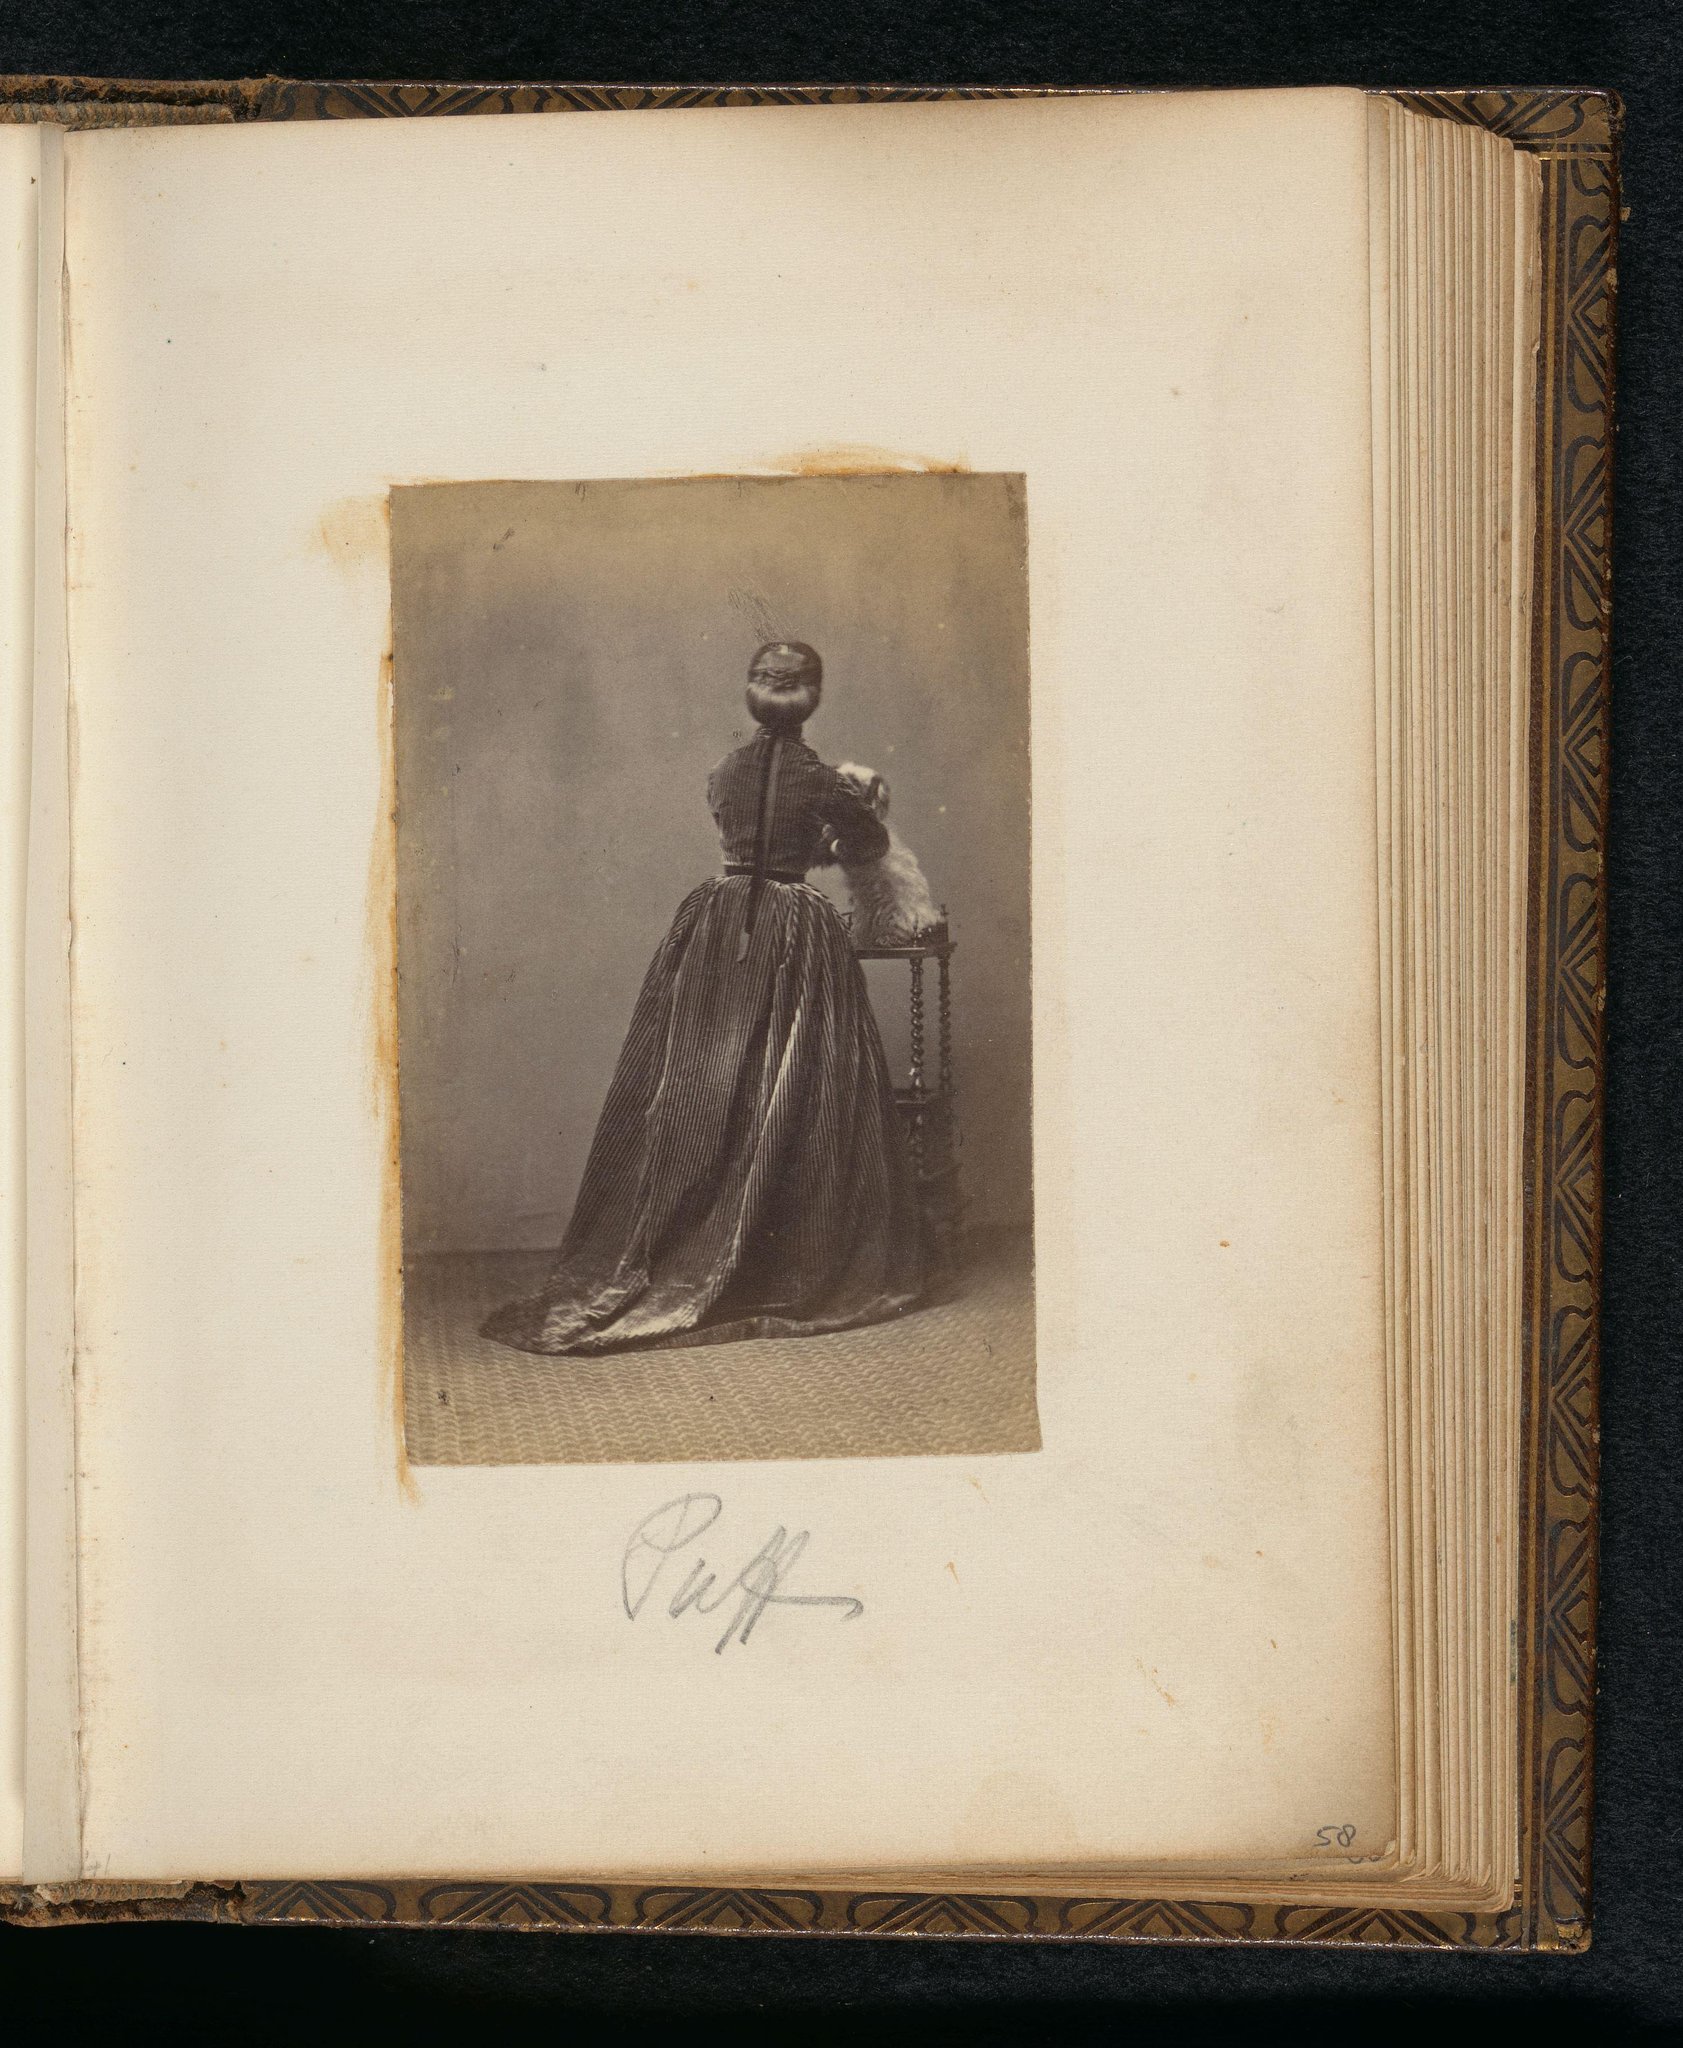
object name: album leaf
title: Vrouw op de rug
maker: Anonymous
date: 1865-1867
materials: cardboard, photographic support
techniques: albumen print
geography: england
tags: anonymous historical person portrayed - bb - woman, dog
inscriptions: annotation: ‘Puff’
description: Staande onbekende vrouw op de rug gezien, naast haar een hondje ('Puff') zittend op een tafel. Foto op albumblad in album met 68 foto's merendeels met geaquarelleerde randversieringen. Het zijn voornamelijk portretten op carte-de-visite formaat.